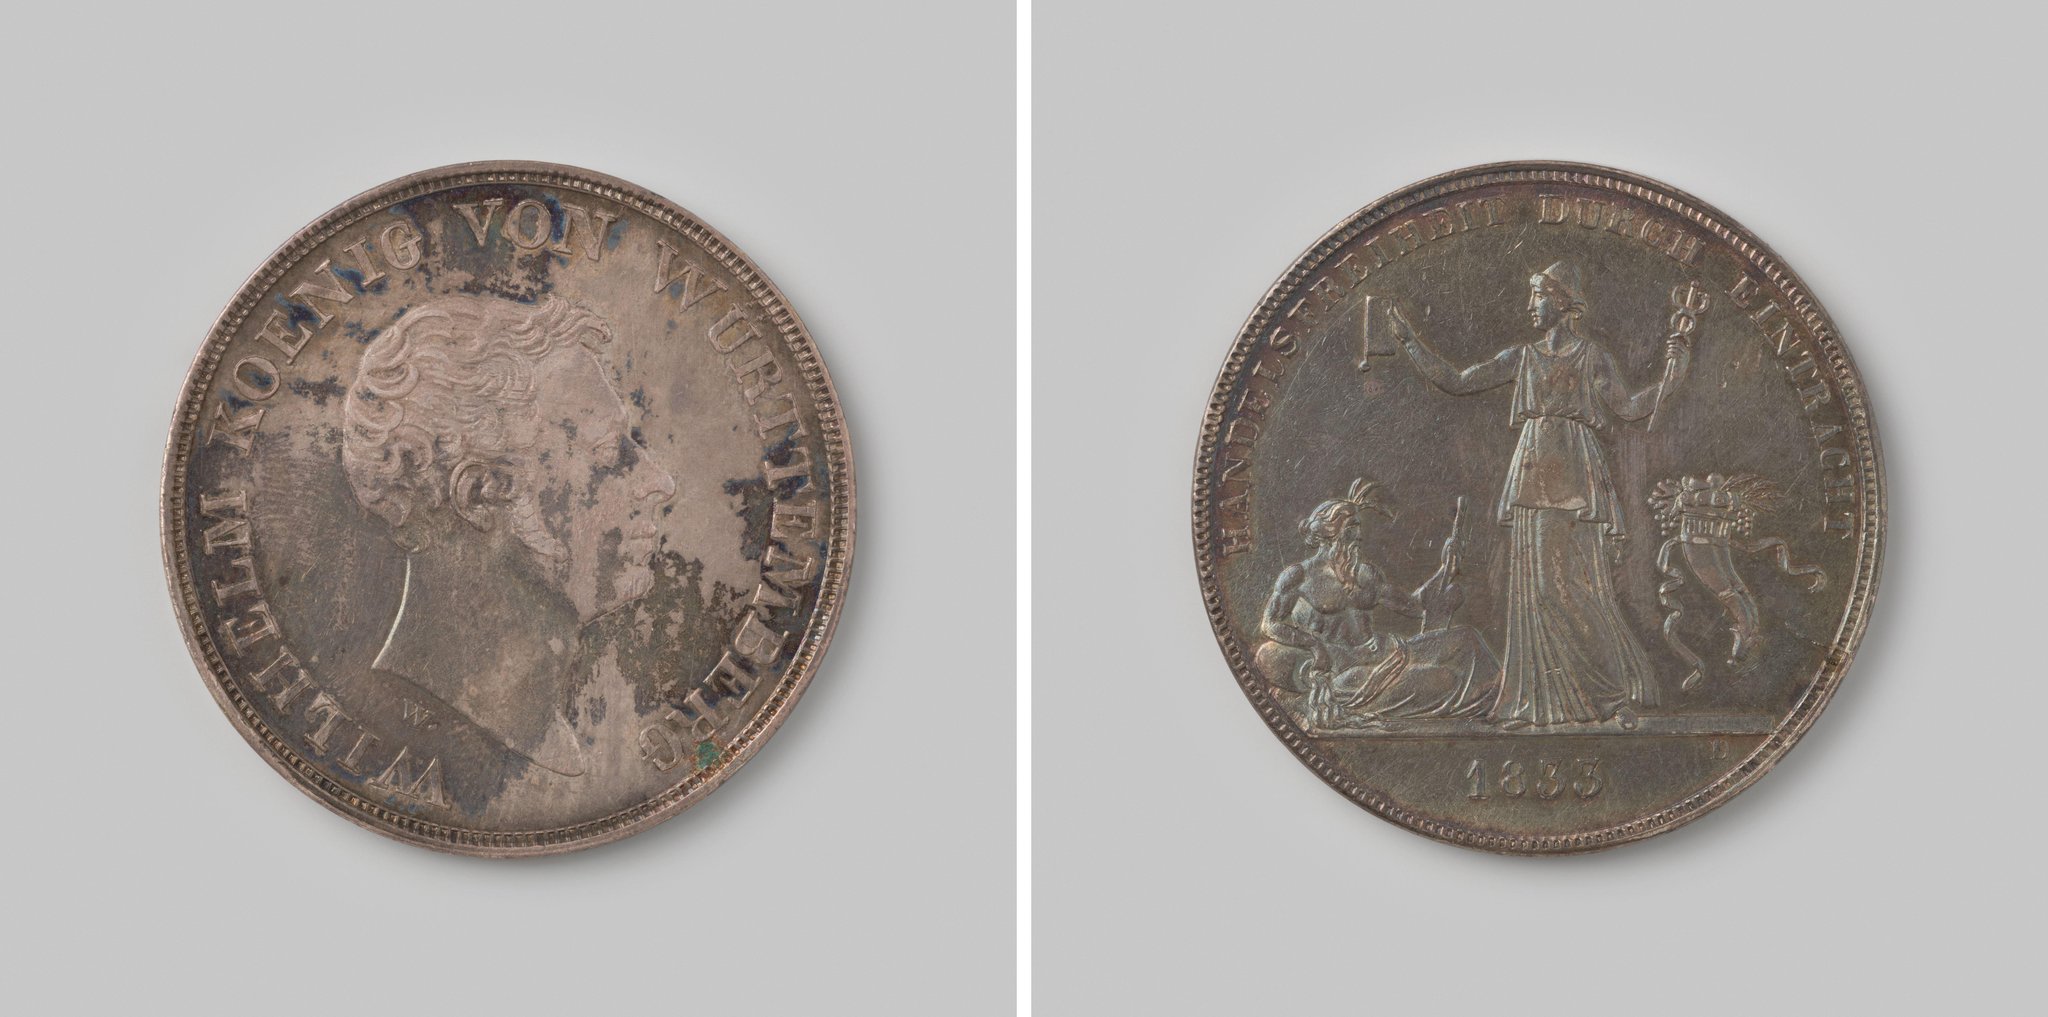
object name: coin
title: Kronentaler uit het koninkrijk Wurtemberg van Wilhelm I, 1833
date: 1833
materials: silver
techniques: striking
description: Zilveren munt. Voorzijde: hoofd van de koning naar links. Keerzijde: allegorische voorstelling. In afsnede jaartal. Waarde-aanduiding: Kronen Thaler in randschrift.